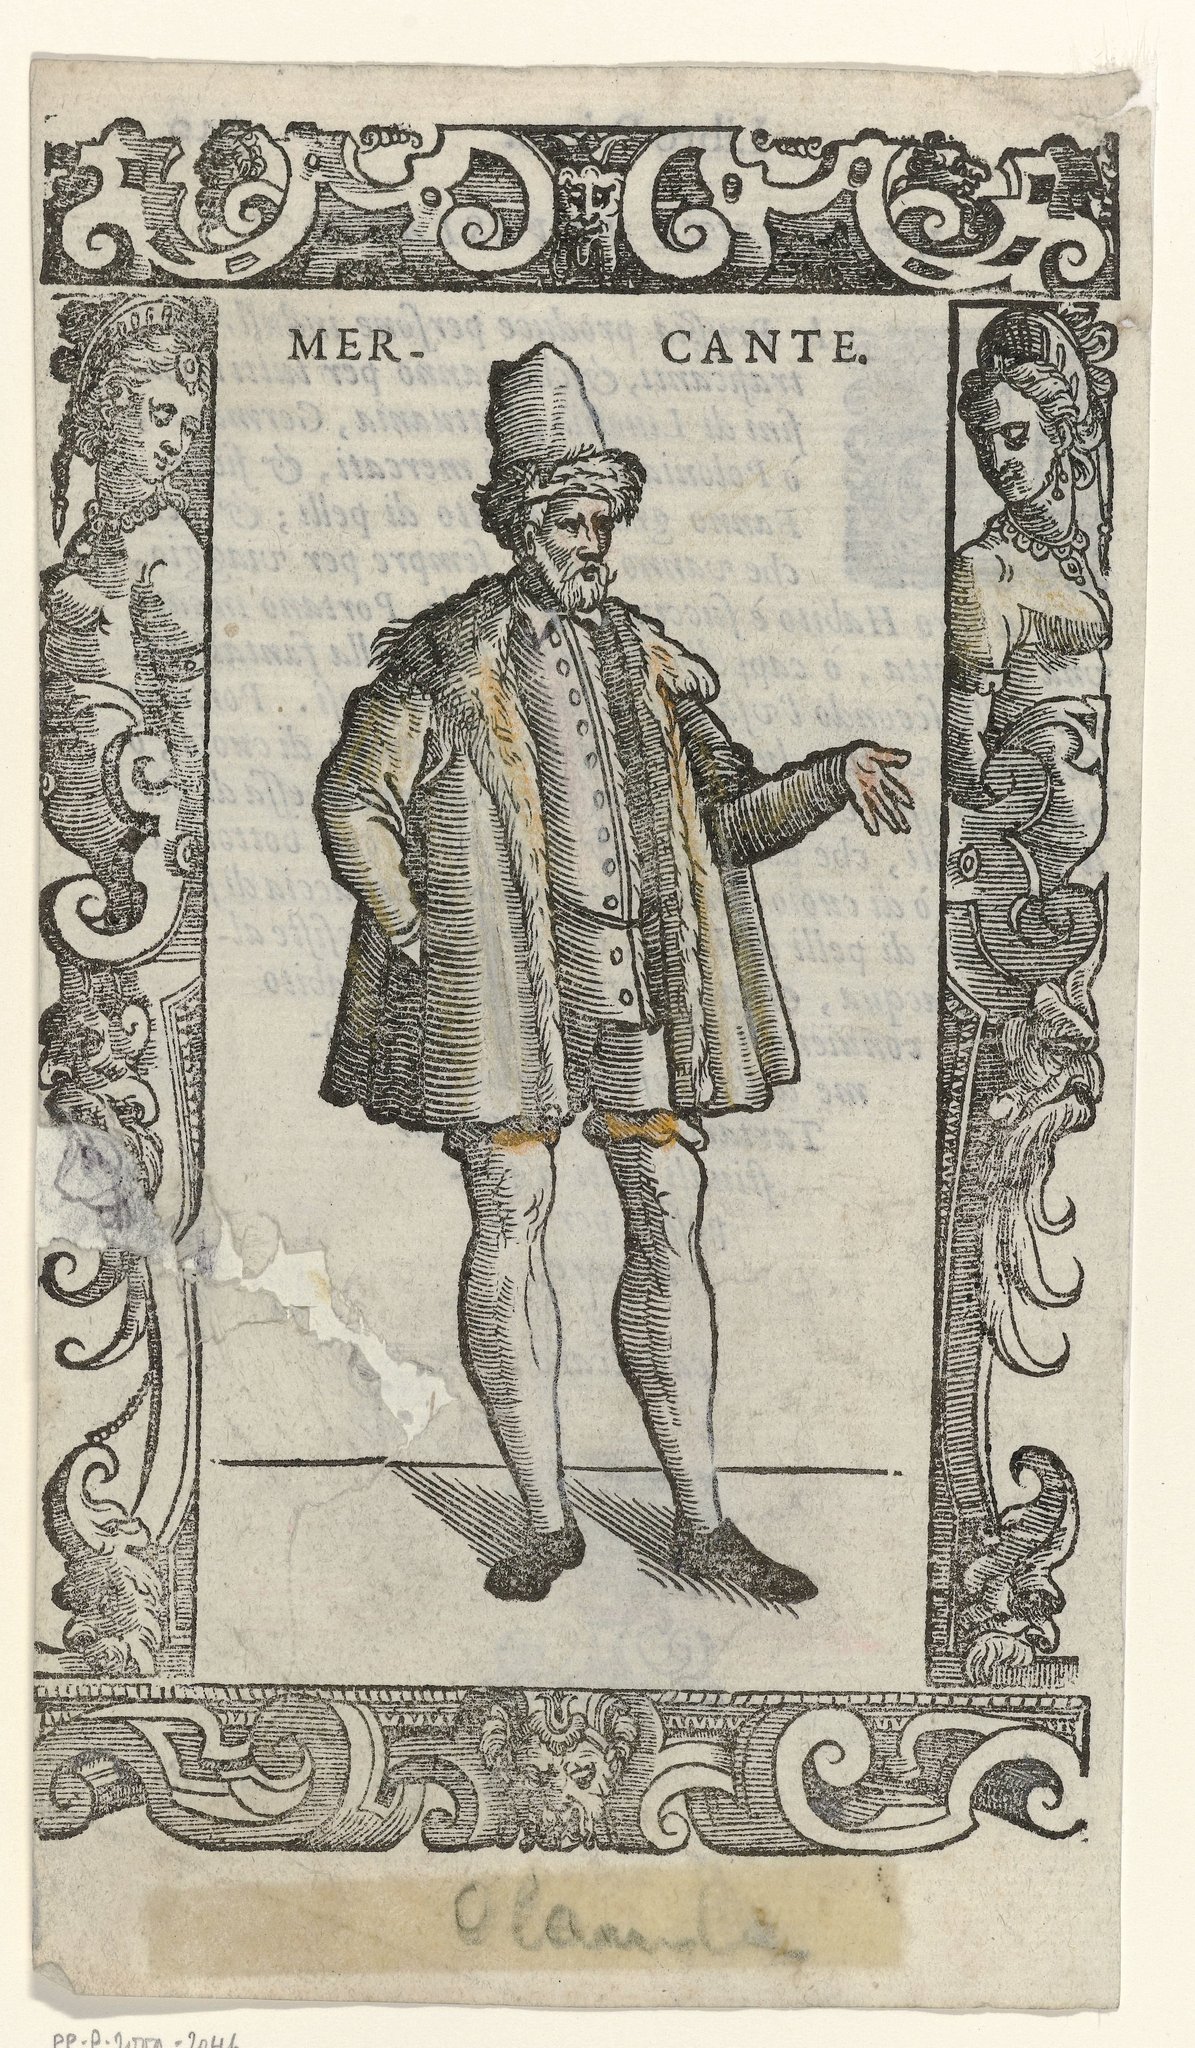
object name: print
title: MERCANTE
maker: christoph krieger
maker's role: print maker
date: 1590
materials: paper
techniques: woodcut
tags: head-gear: hat (+ men's clothes), clothes, costume (+ men's clothes)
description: Koopman, gekleed in korte mantel, afgezet met bont. Hoge hoed op het hoofd. uit: Vecellio...in ornamentrand